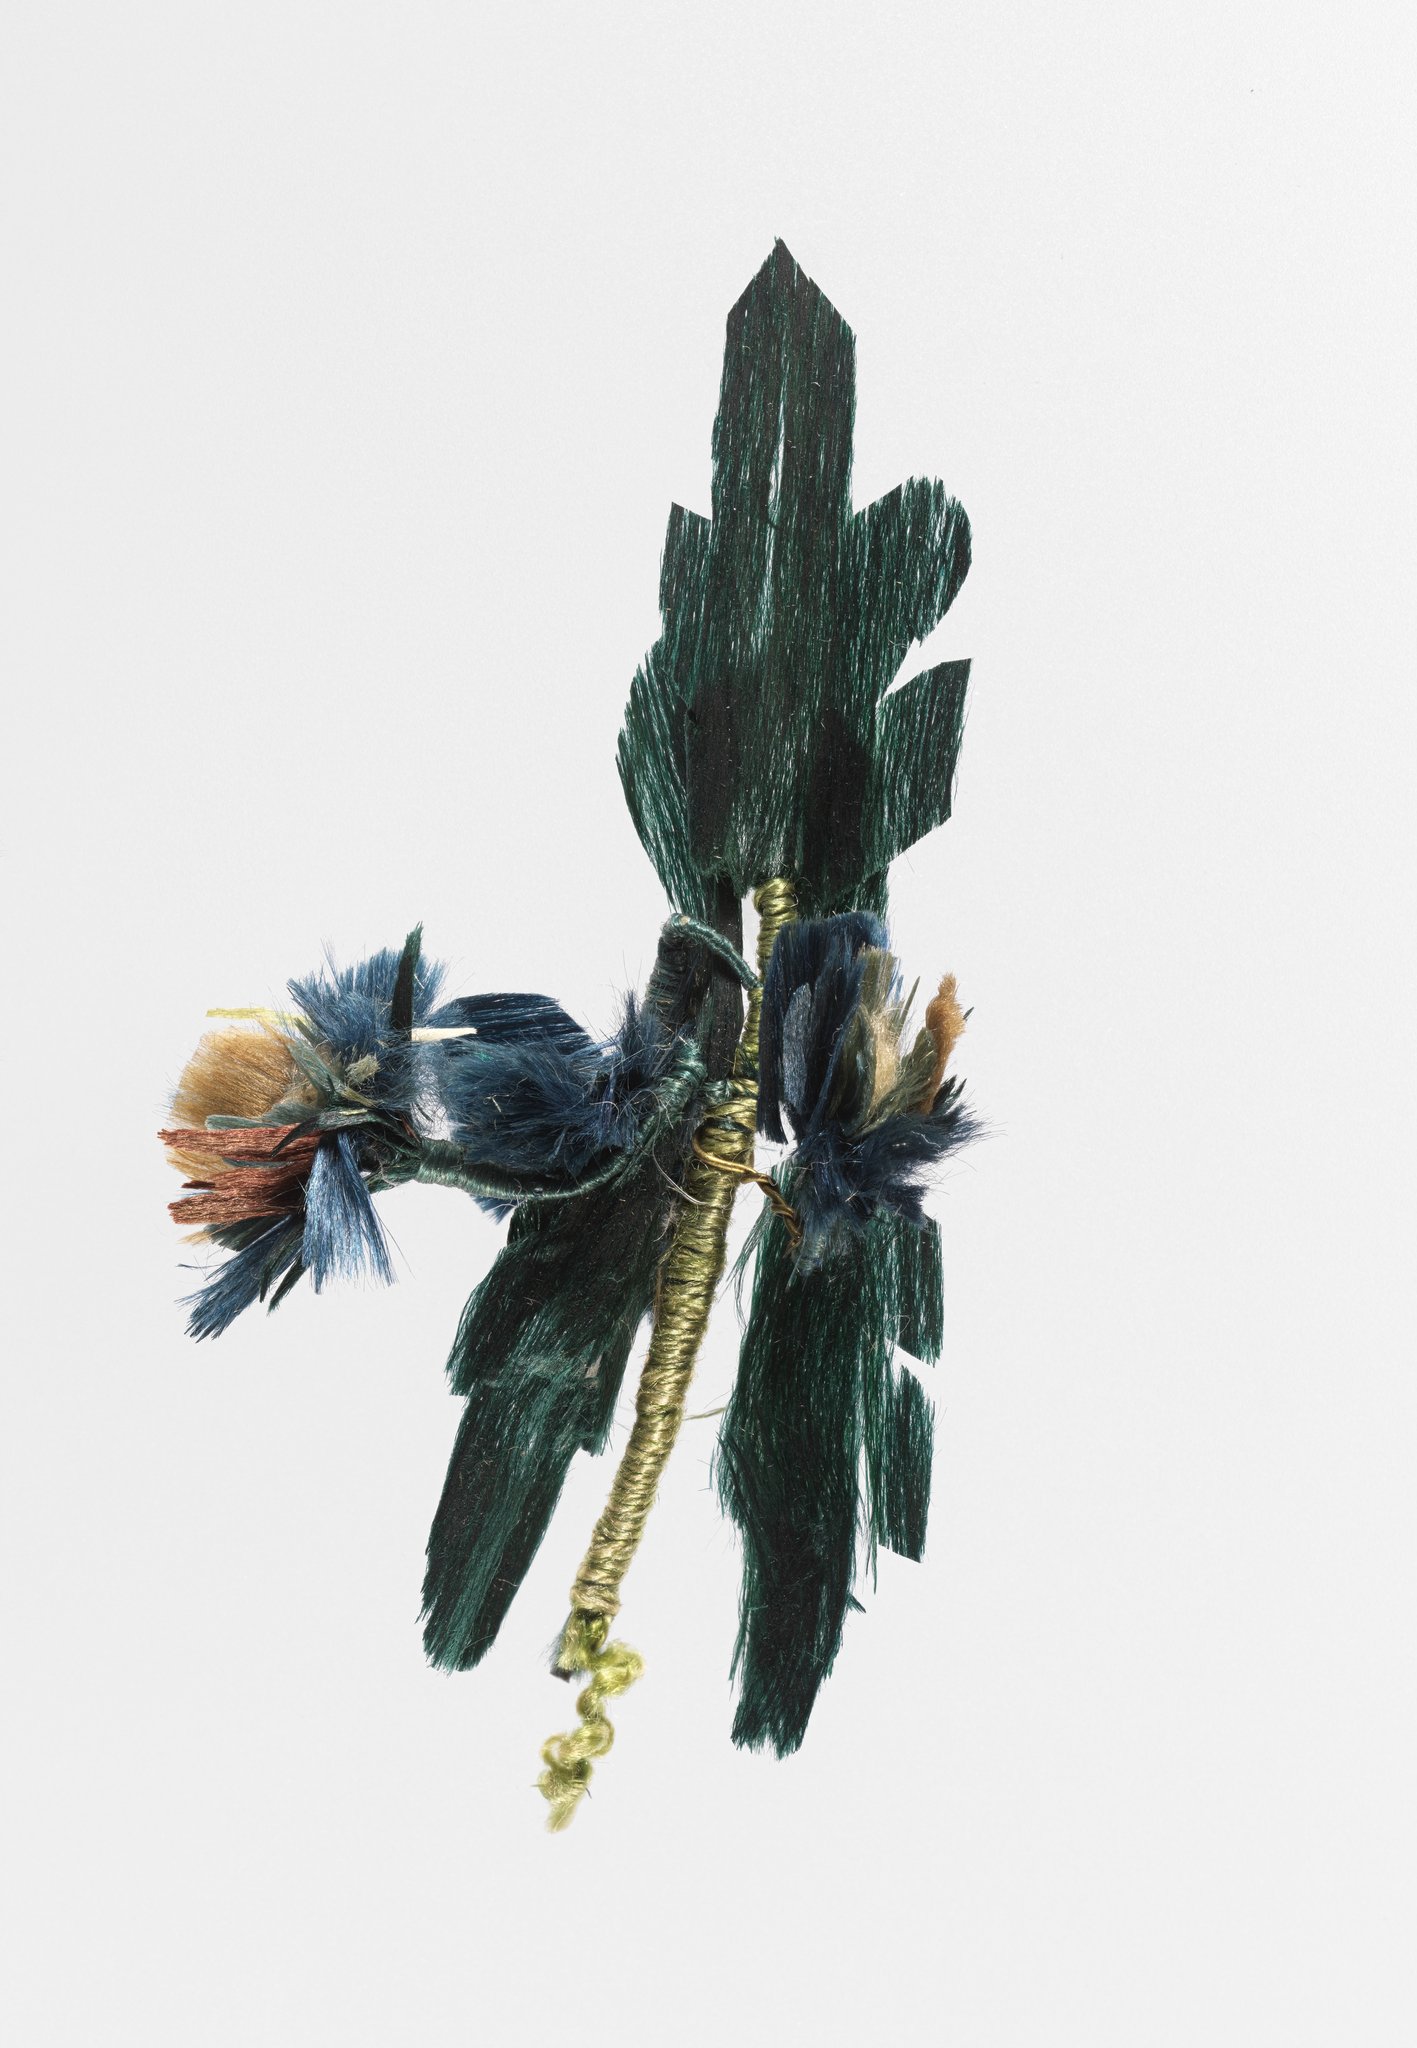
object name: boutonnière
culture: british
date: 1625-1649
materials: silk